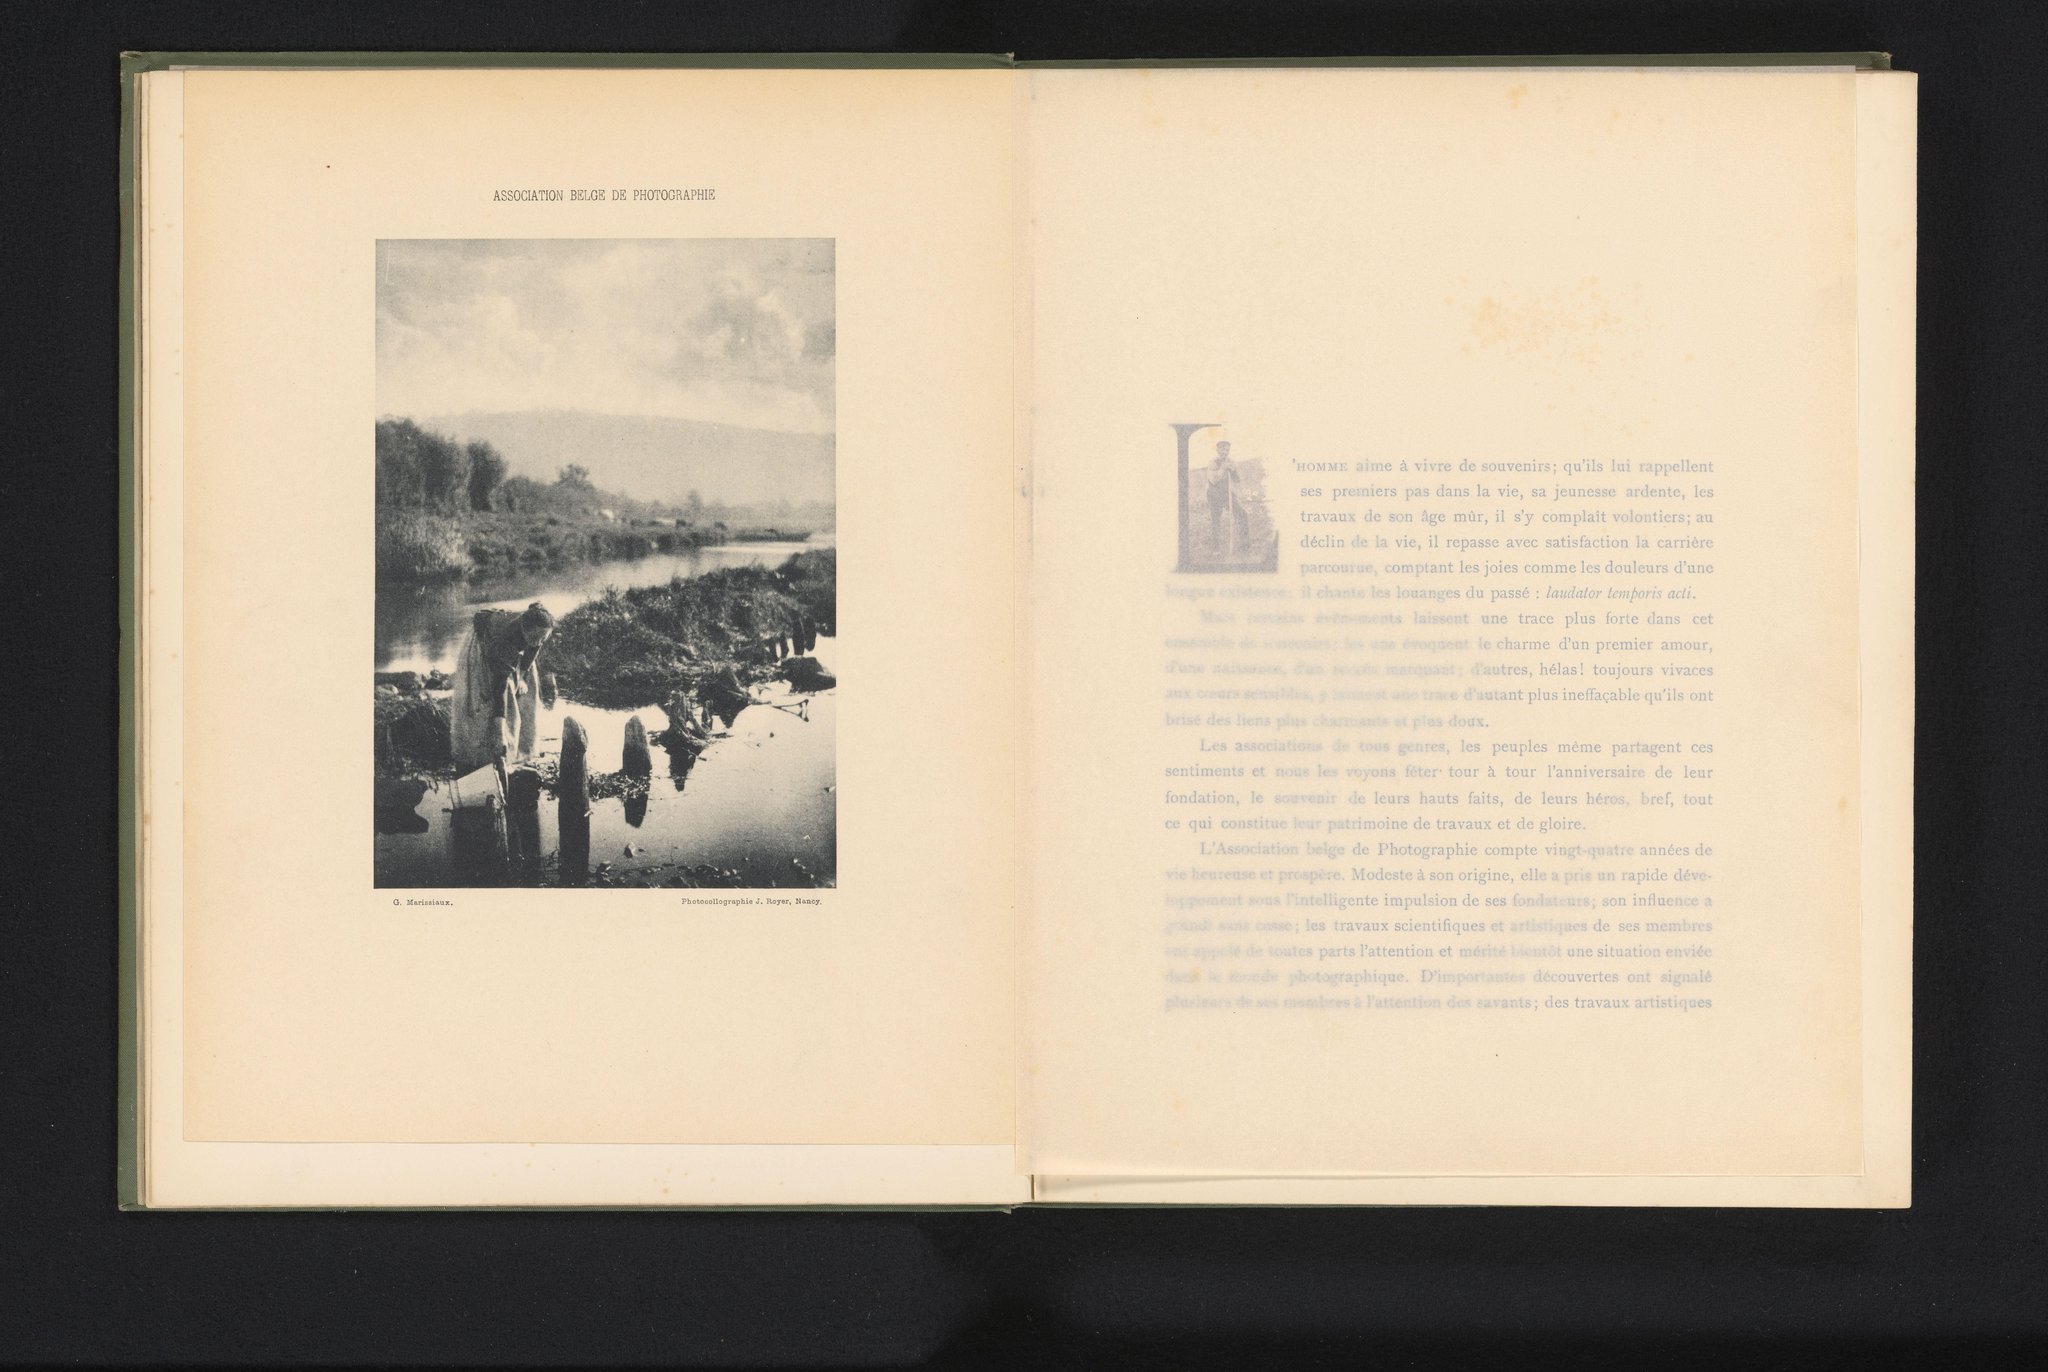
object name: page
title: Landschap met een onbekende vrouw die water haalt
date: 1893-1898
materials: paper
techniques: photograph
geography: nancy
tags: landscapes, historical persons - bb - woman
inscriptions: inscription: ‘Association Belge de photographie’